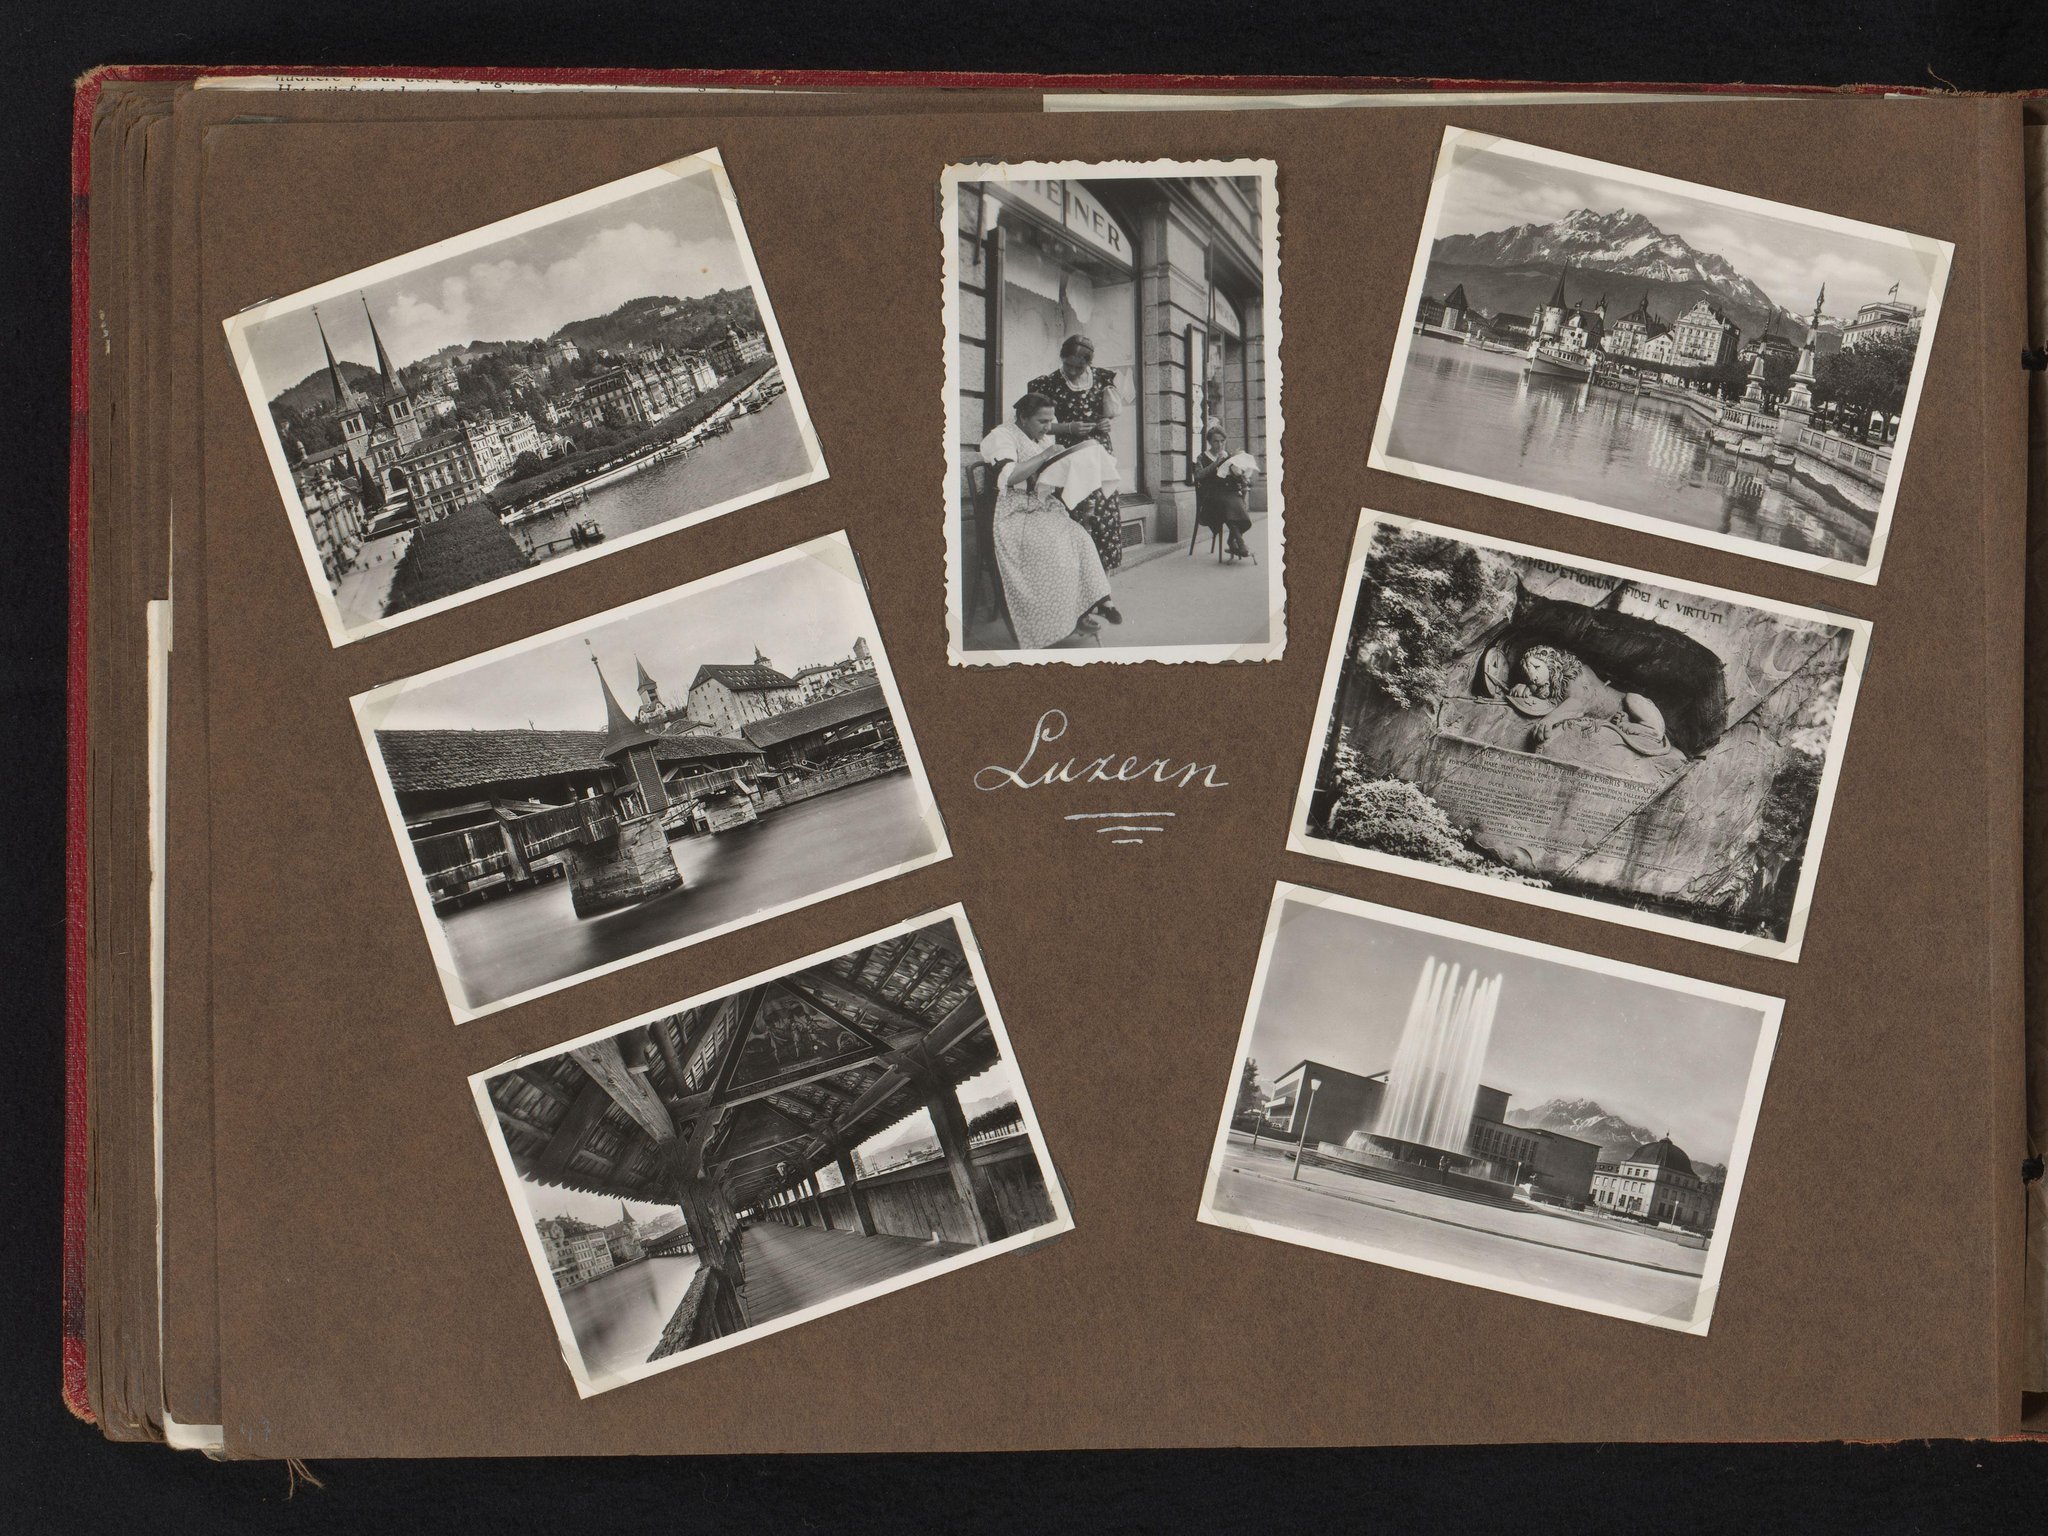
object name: photograph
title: Luzern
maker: Anonymous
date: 1908-1937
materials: paper, photographic support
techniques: gelatin silver print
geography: switzerland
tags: city-view in general; 'veduta', outing, pleasure trip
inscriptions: inscription: ‘Luzern’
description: Albumblad met zeven, merendeels gekochte, foto's van Luzern. Verslag van een elfdaagse groepsreis per autobus naar Zwitserland van 2 tot en met 12 augustus 1937. Onderdeel van het reisalbum van de familie Van den Broek 1935-1937.